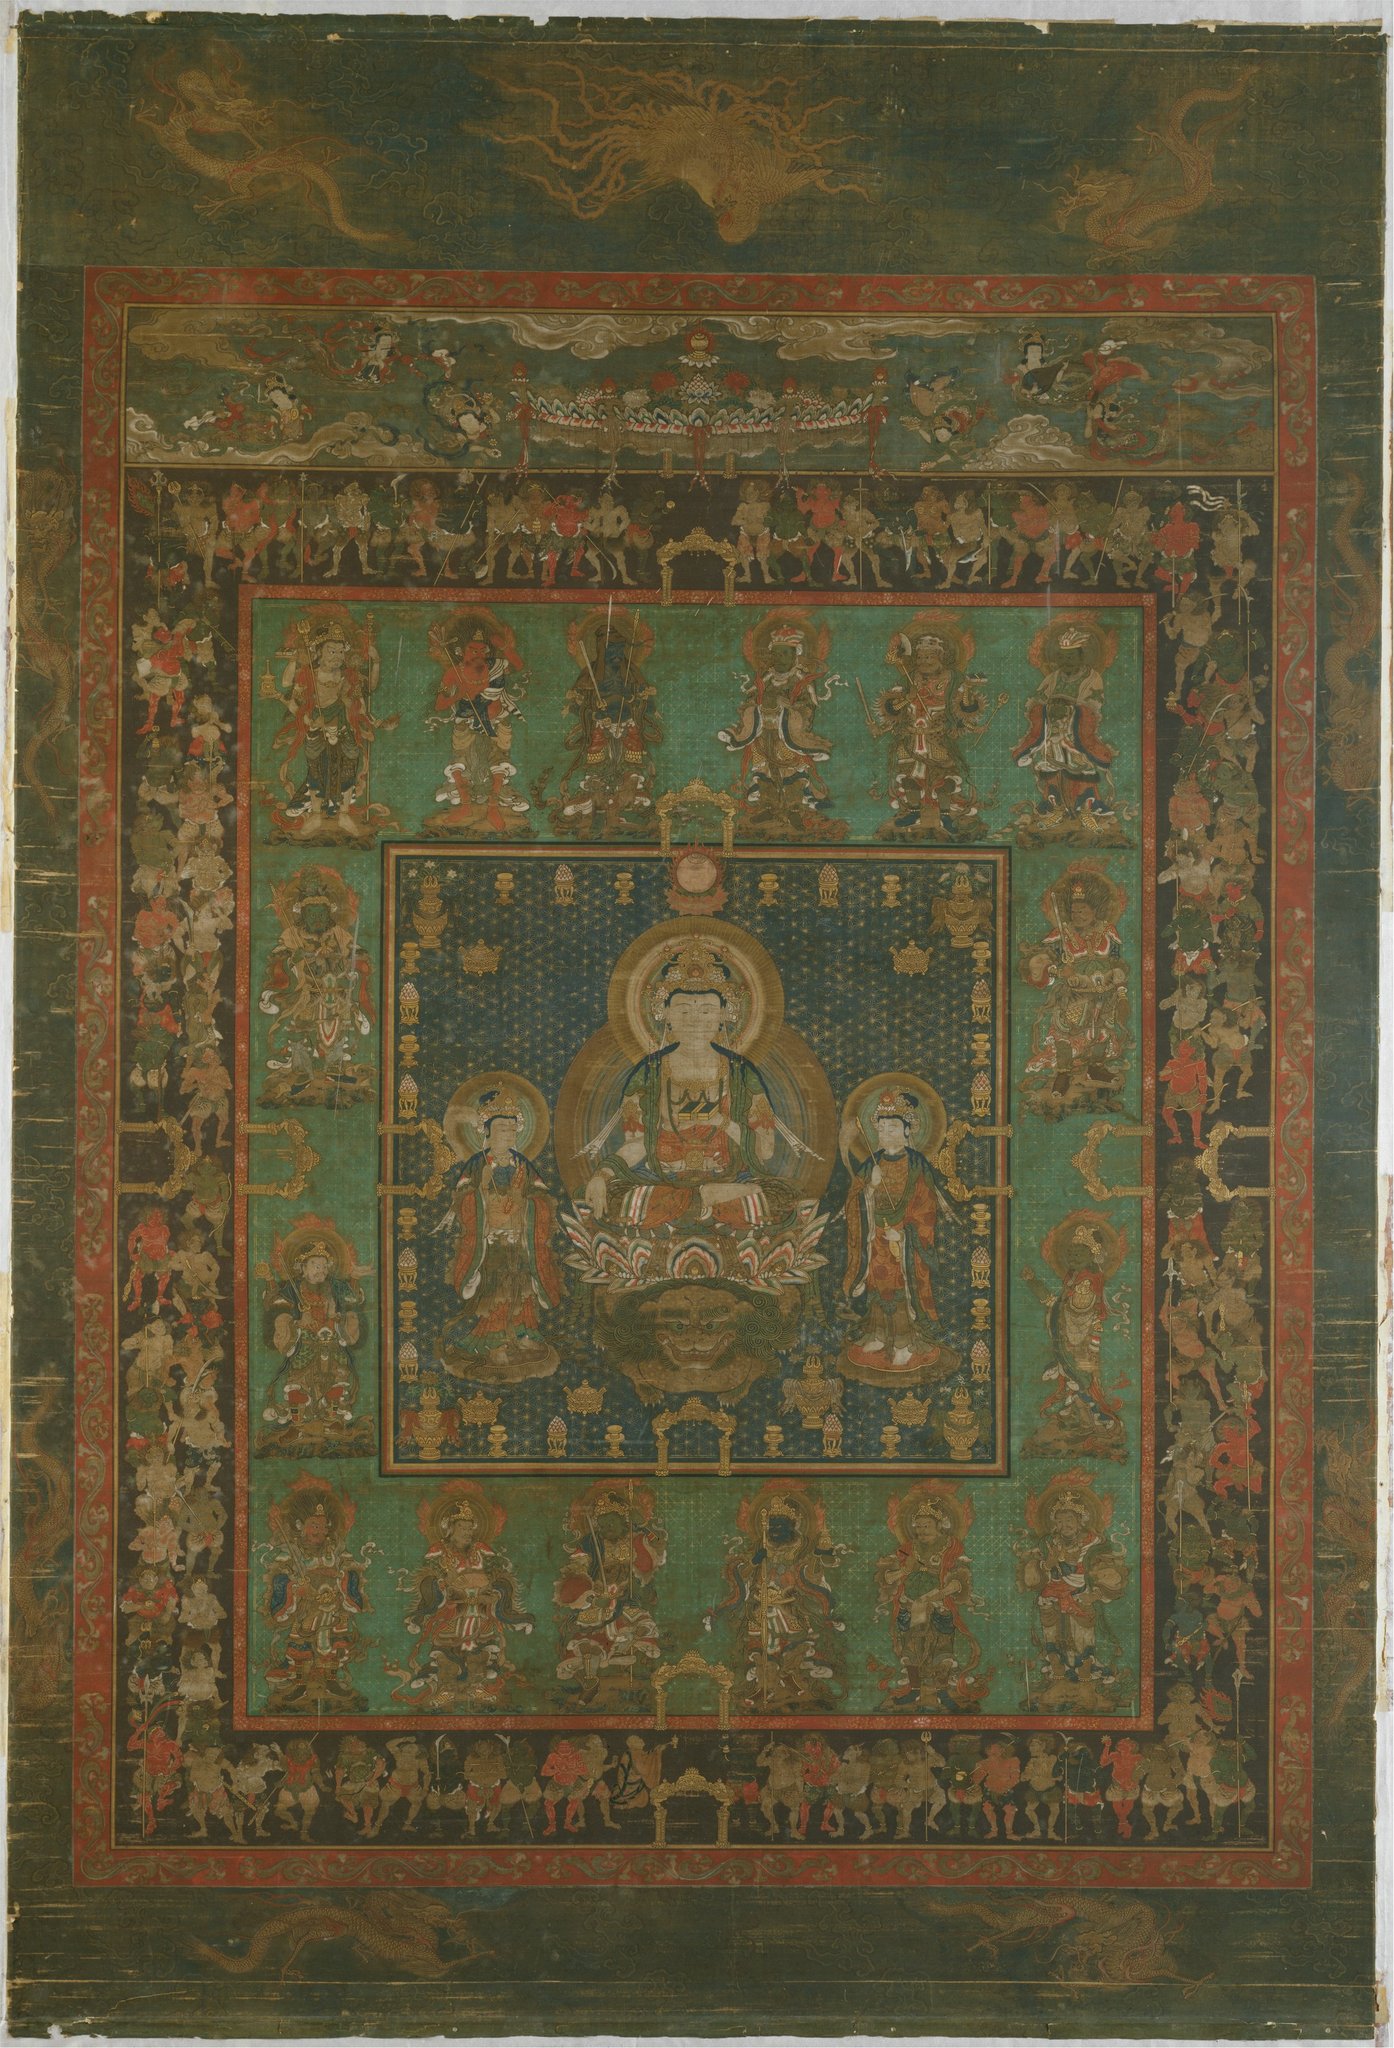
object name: hanging scroll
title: Mandala of the Bodhisattva Hannya (Prajnaparamita)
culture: japanese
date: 1301-1400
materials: gold, gold foil, ink, silk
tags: dragons,buddhism,bodhisattvas,deities,demons,musicians